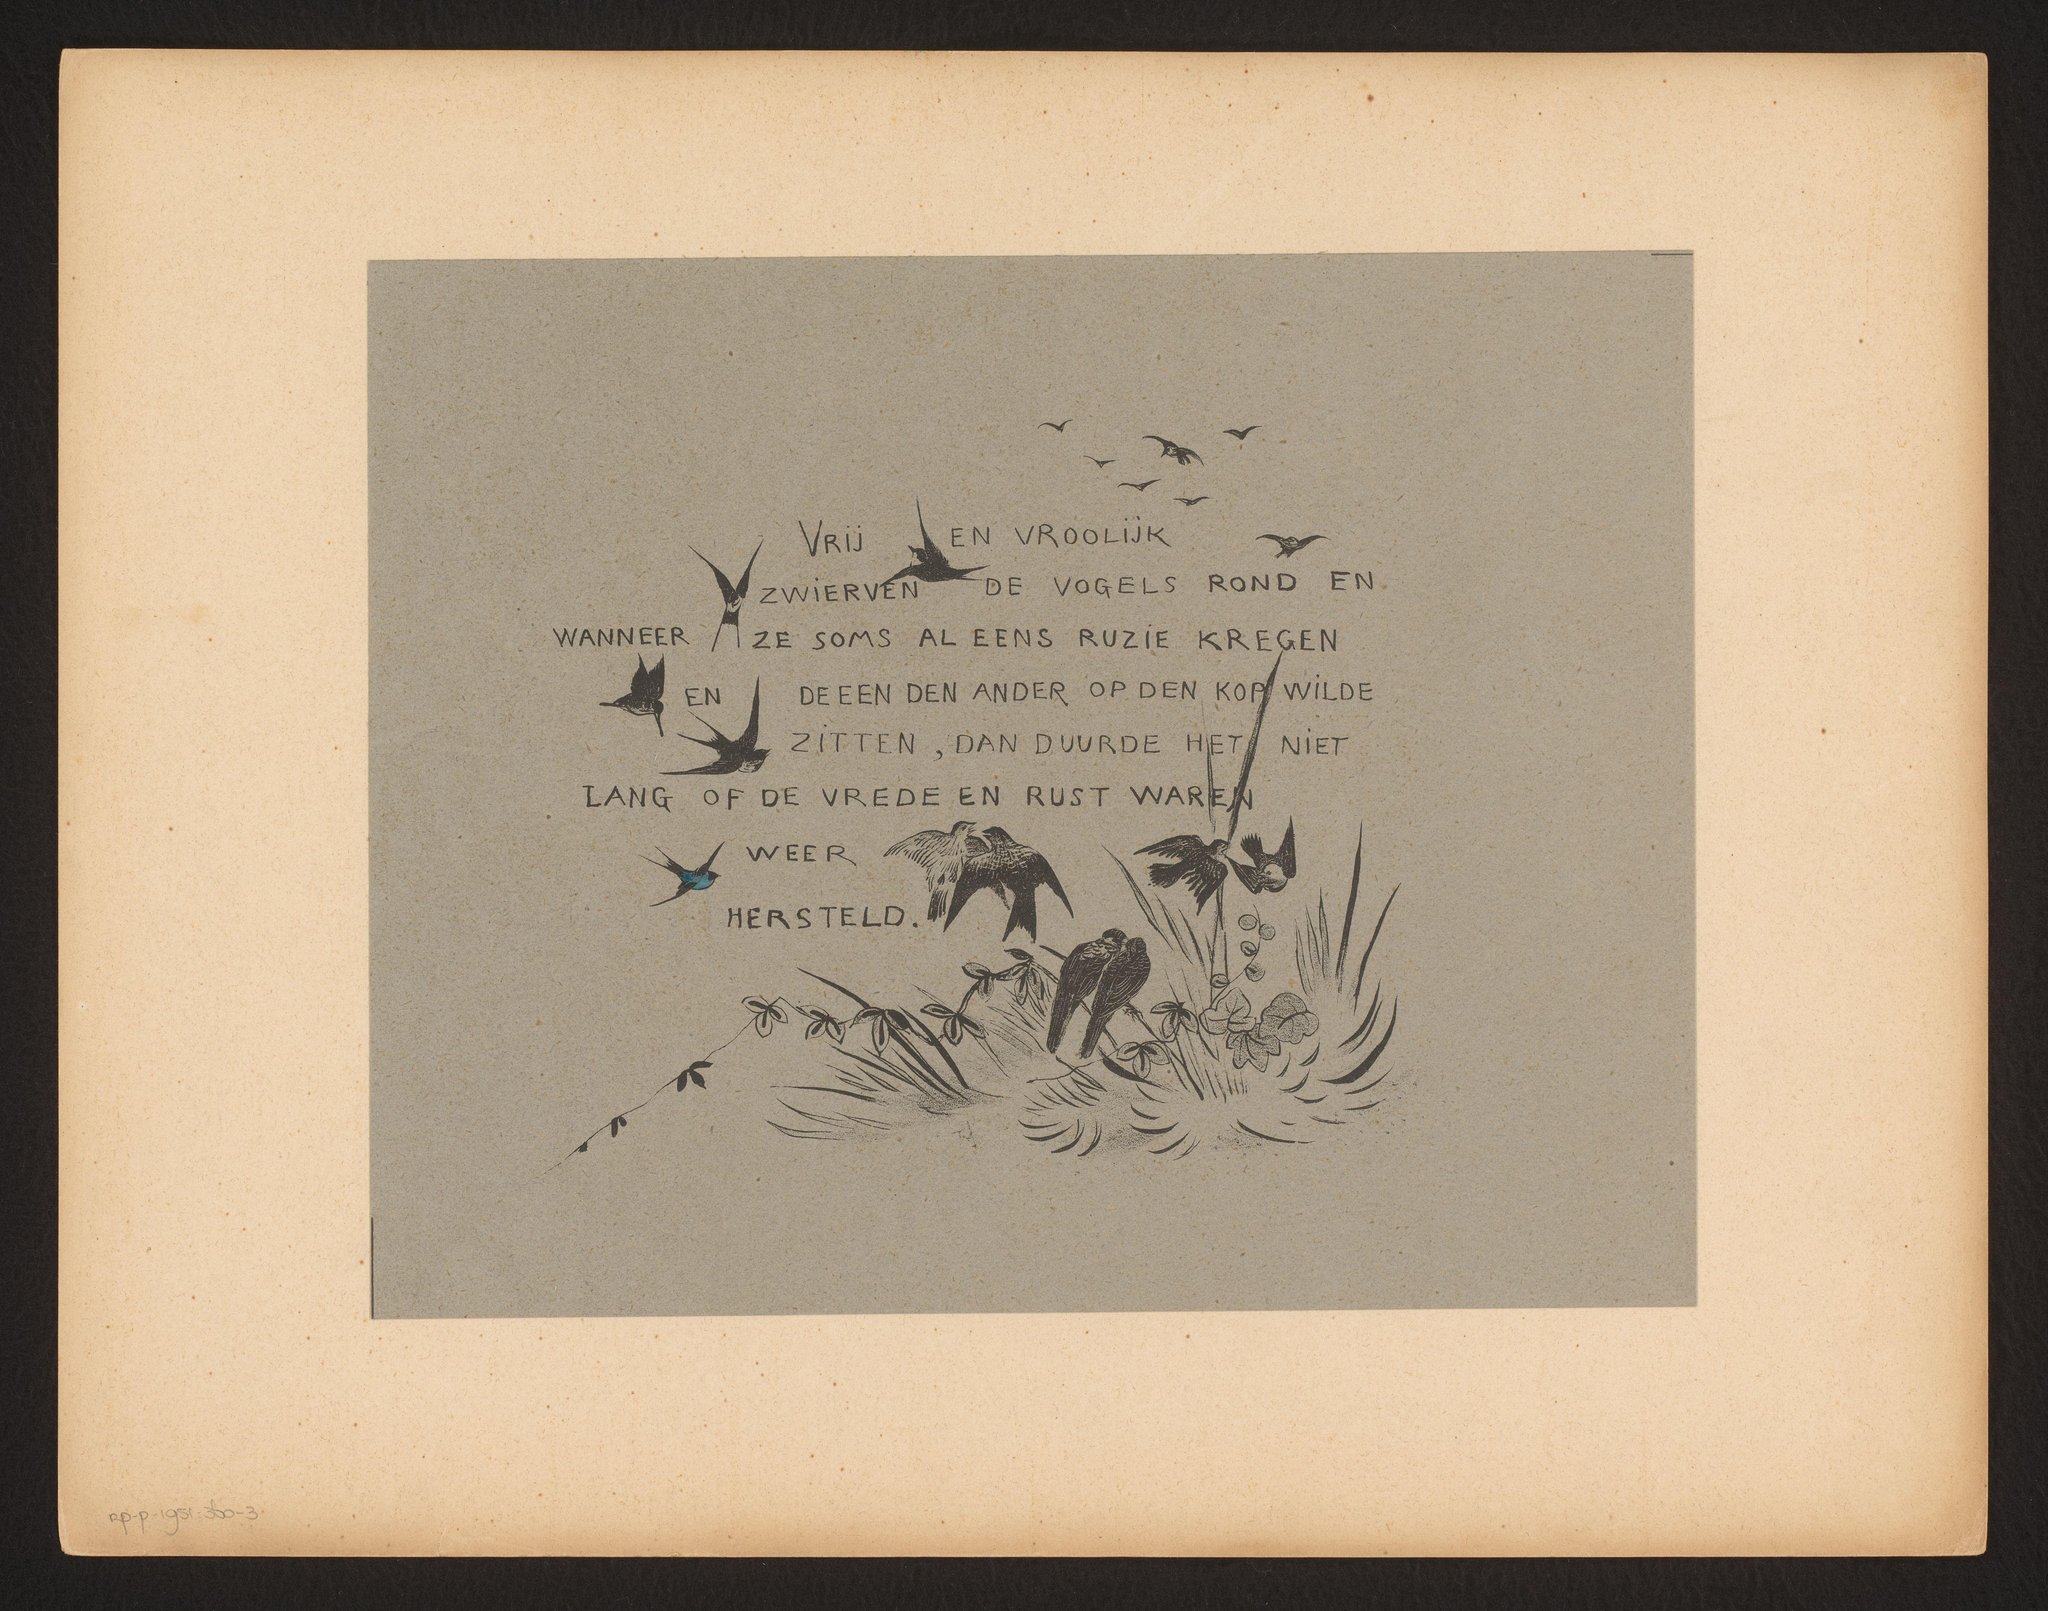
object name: print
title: Tekstblad met zwaluwen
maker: theo van hoytema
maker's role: draughtsman, painter, print maker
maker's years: 1863-1917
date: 1892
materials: paper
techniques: hand coloring, lithograph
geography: the hague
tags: song-birds: swallow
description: Zowel tekst als afbeelding zijn gelithografeerd.